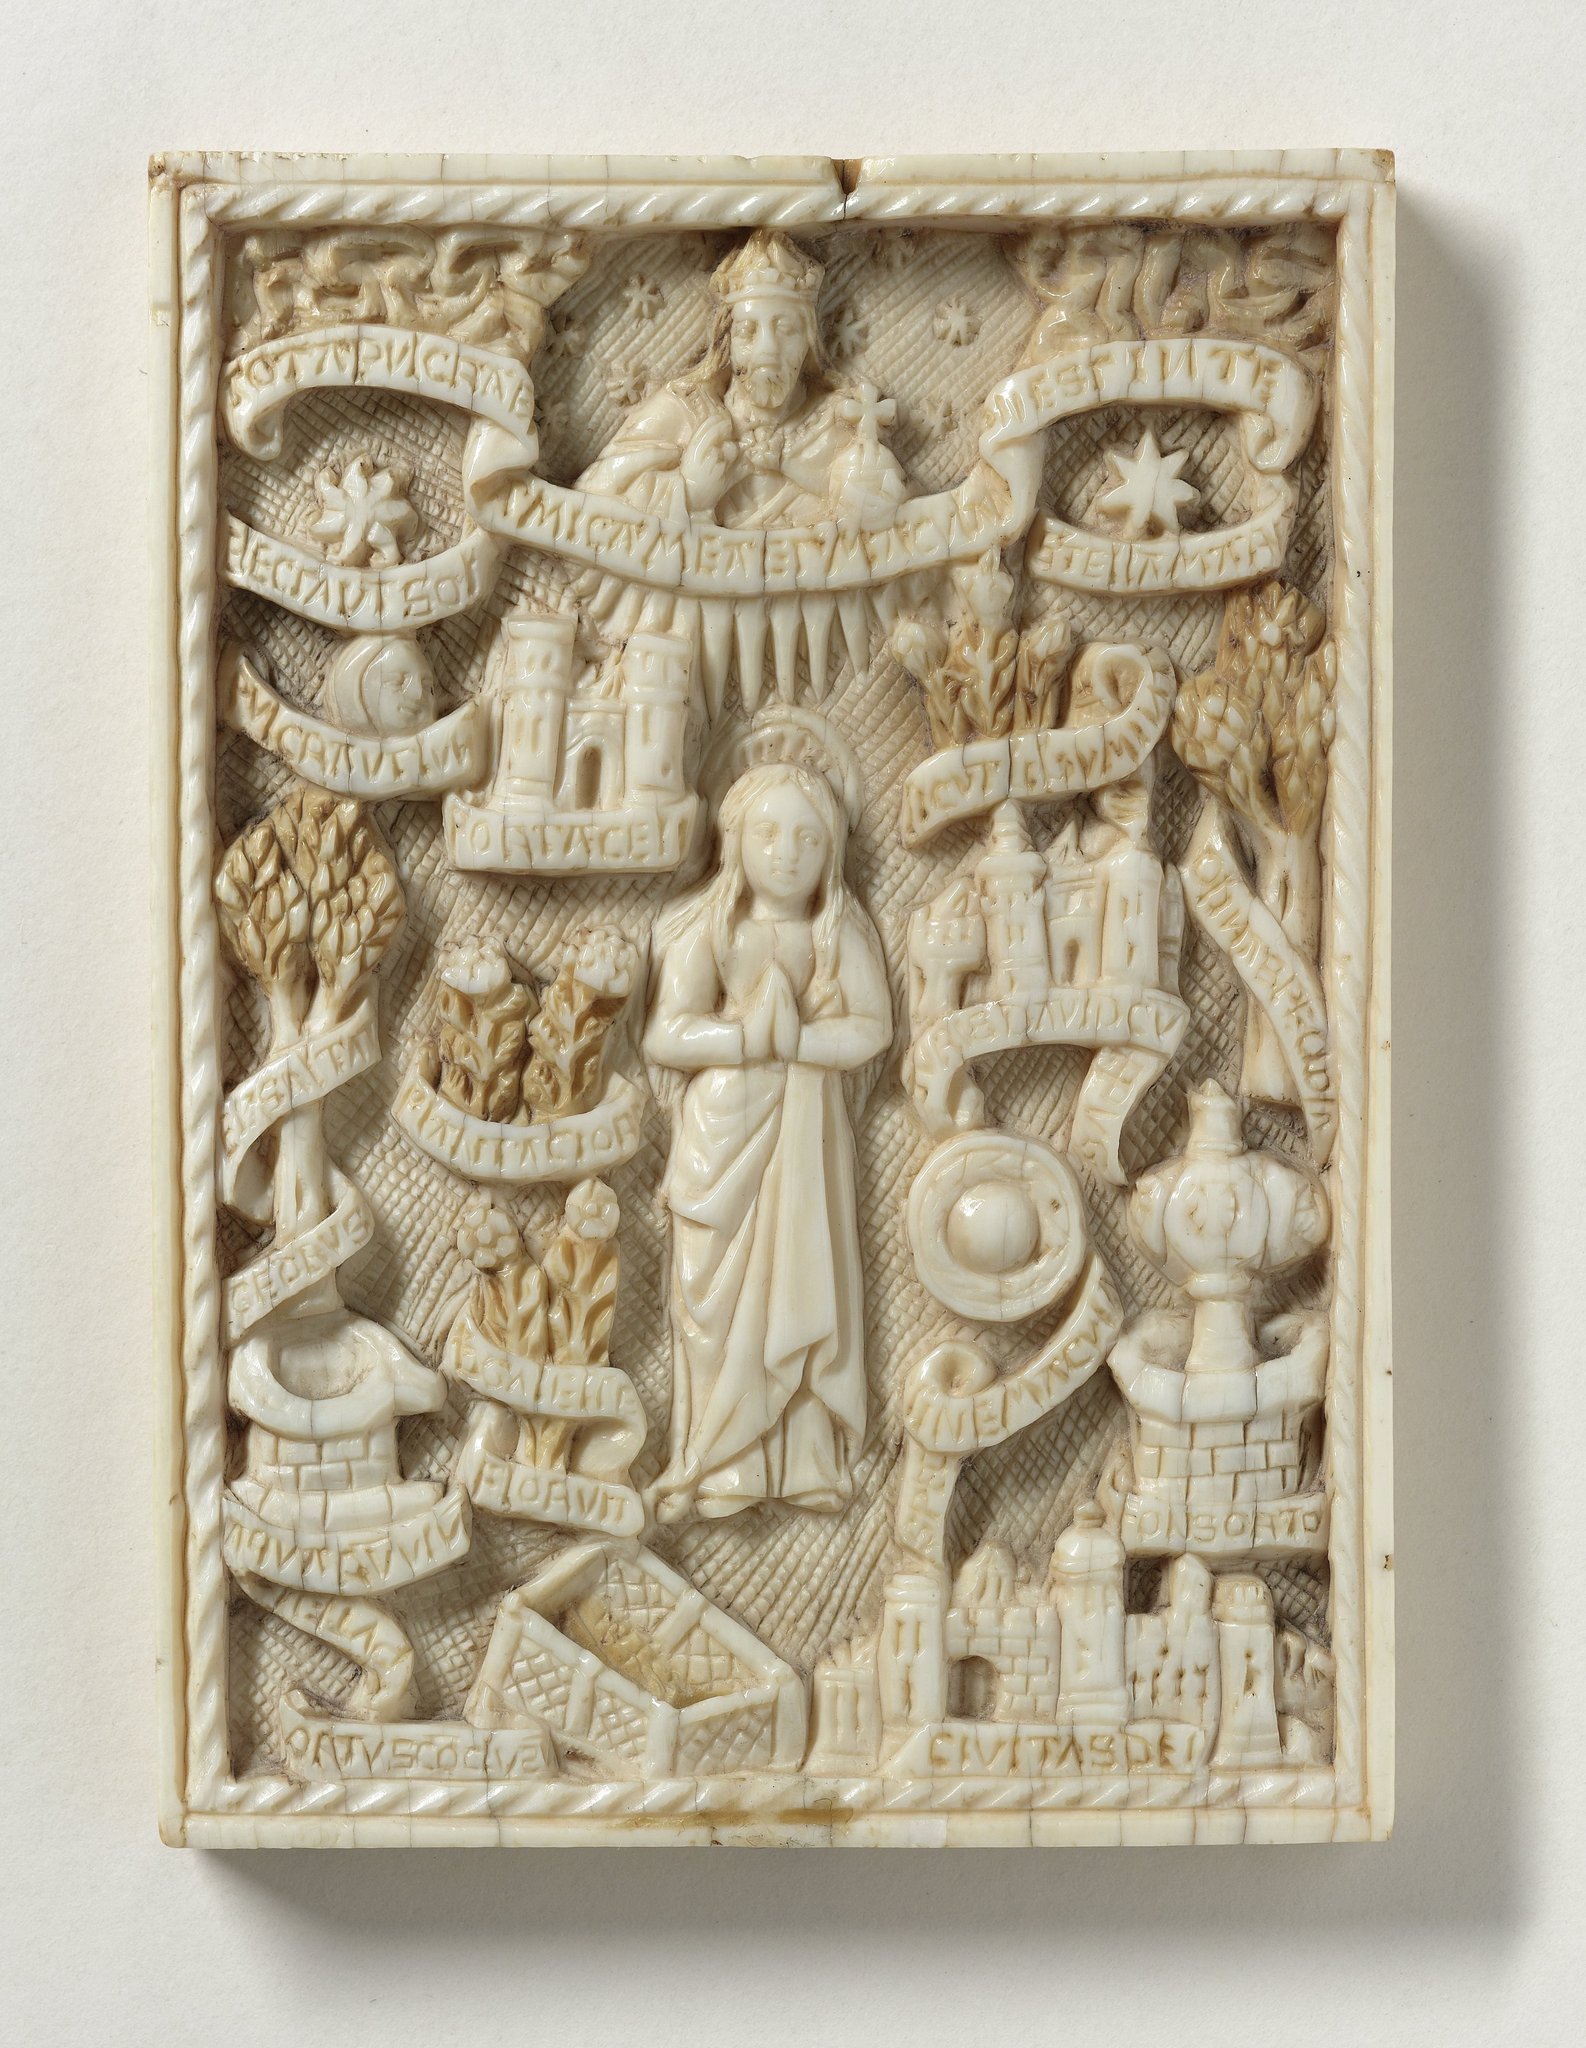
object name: relief sculpture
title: Maria Immaculata, with Symbols of her Immaculate Conception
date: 1520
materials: ivory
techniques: cutting, polychromy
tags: 'defensorium inviolatae virginitatis'; symbols of virginal motherhood, god the father, symbols of mary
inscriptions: inscription, on the banderole beneath the rose, left of Mary, incised: ‘PIANTACIO R[osae]’, inscription, on the banderole beneath the sun above left, incised: ‘ELECTA VT SOL’, inscription, on the banderole beneath the enclosed garden, bottom centre, incised: ‘[h]ORTVS CONCLVSV[s]’, inscription, on the banderole around the two blossoming shoots, left of Mary’s legs, incised: ‘[vi]RGA IESSE FLORVIT’, inscription, on the reverse, incised: ‘barthelemy PRINET 1758’, inscription, on the banderole around the olive tree, far right, incised: ‘OLIVA SPECIO[s]A’, inscription, on the banderole around the cedar tree, far left, incised: ‘CEDRVS EXSALTAT [a]’, inscription, on the banderole beneath the fountain, far right, incised: ‘FONS [h]ORTO[rum]’, inscription, on the banderole beneath the star upper right, incised: ‘STELLA MARIS’, inscription, on the banderole beneath the lily between thistles, beneath the star on the right, incised: ‘SICVT [l]I[l]IVM INT[er spinas]’, inscription, on the banderole beneath the moon above left, incised: ‘PVLC[h]RA VT LVN[a]’, inscription, on the banderole beneath the well, bottom far left, incised: ‘PVTEV[s] AQVAR[ium] VIVENT[ium]’, inscription, on the banderole beneath the city, bottom far right, incised, inscription, on the banderole of God the Father, incised: ‘TOTA PVLC[h]RA E[s]AMICA MEA ET MACVLA [non] EST IN TE’, inscription, on the banderole beneath the Tower of David, on the right next to Mary, incised: ‘TVR[r]IS DAVID CV[m] P[ro]PVG[naculis]’, inscription, on the banderole beneath the heavenly gate, incised: ‘PORTA C[o]ELI’, inscription, on the banderole beneath the convex mirror, right of Mary’s legs, incised: ‘SPEC[ulum] SINE MACVLA’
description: The idea that the Virgin was ‘immaculate’ (free from sin) was generally accepted by the Catholic Church only at the end of the 15th century. This depiction of Mary surrounded by symbols of her purity, such as the lily, dates from about that time. The enclosed garden and the mirror allude to her virginity. The panel’s clear symbols and texts inspired worshippers while praying.